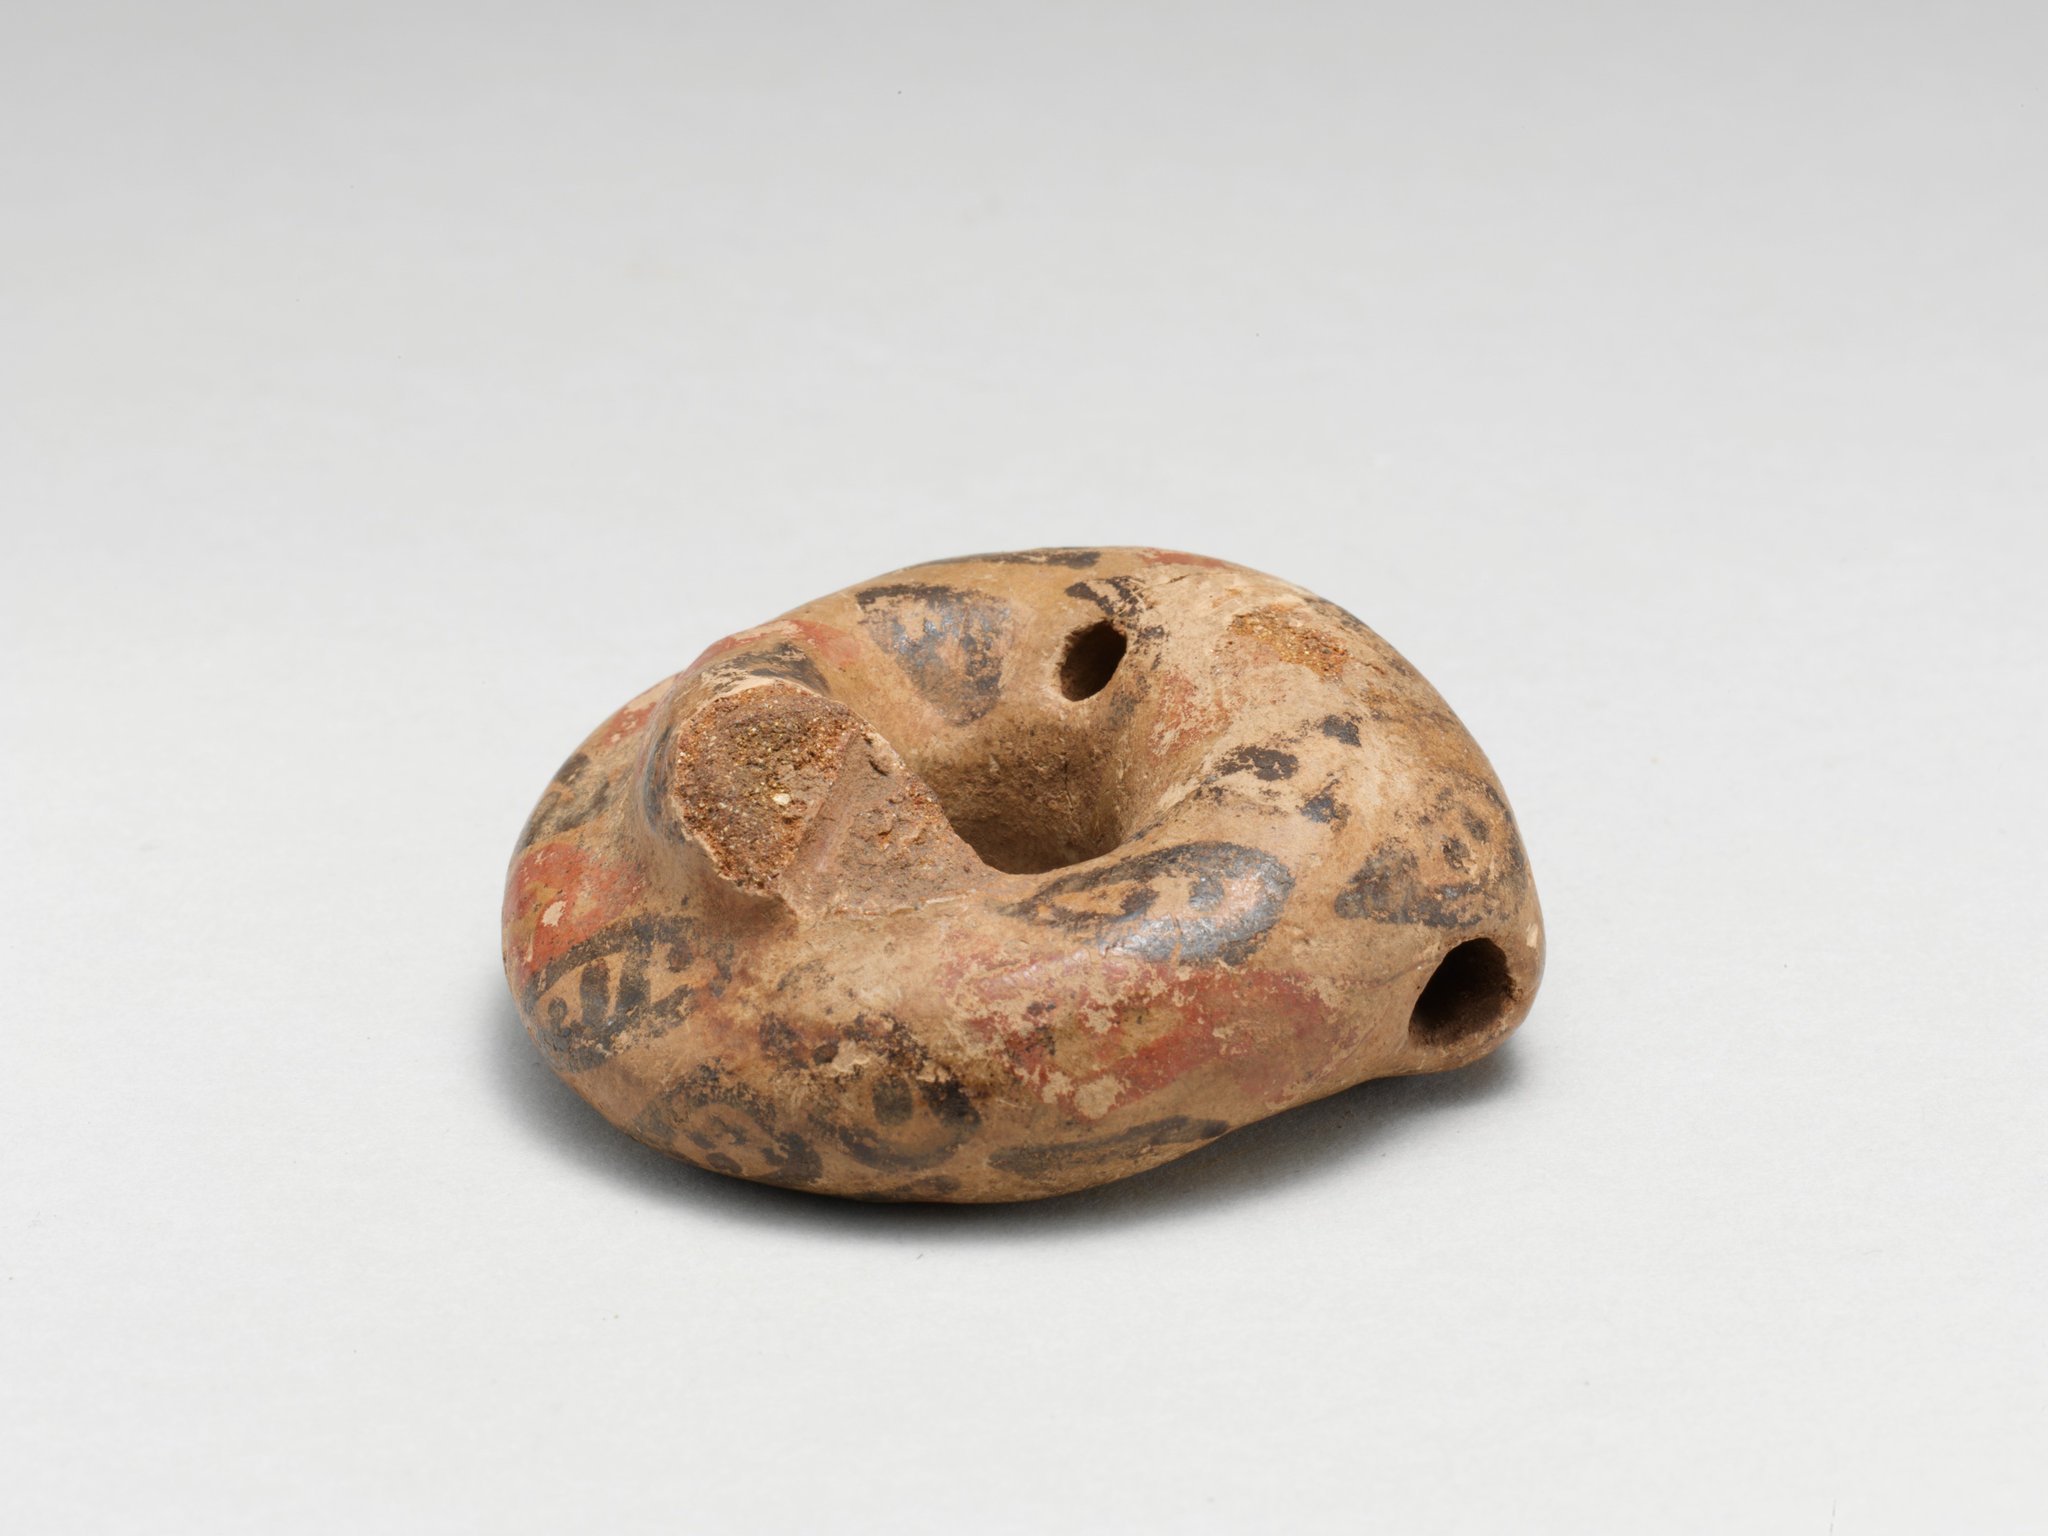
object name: pottery whistle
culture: costa rican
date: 800-1525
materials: clay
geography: costa rica